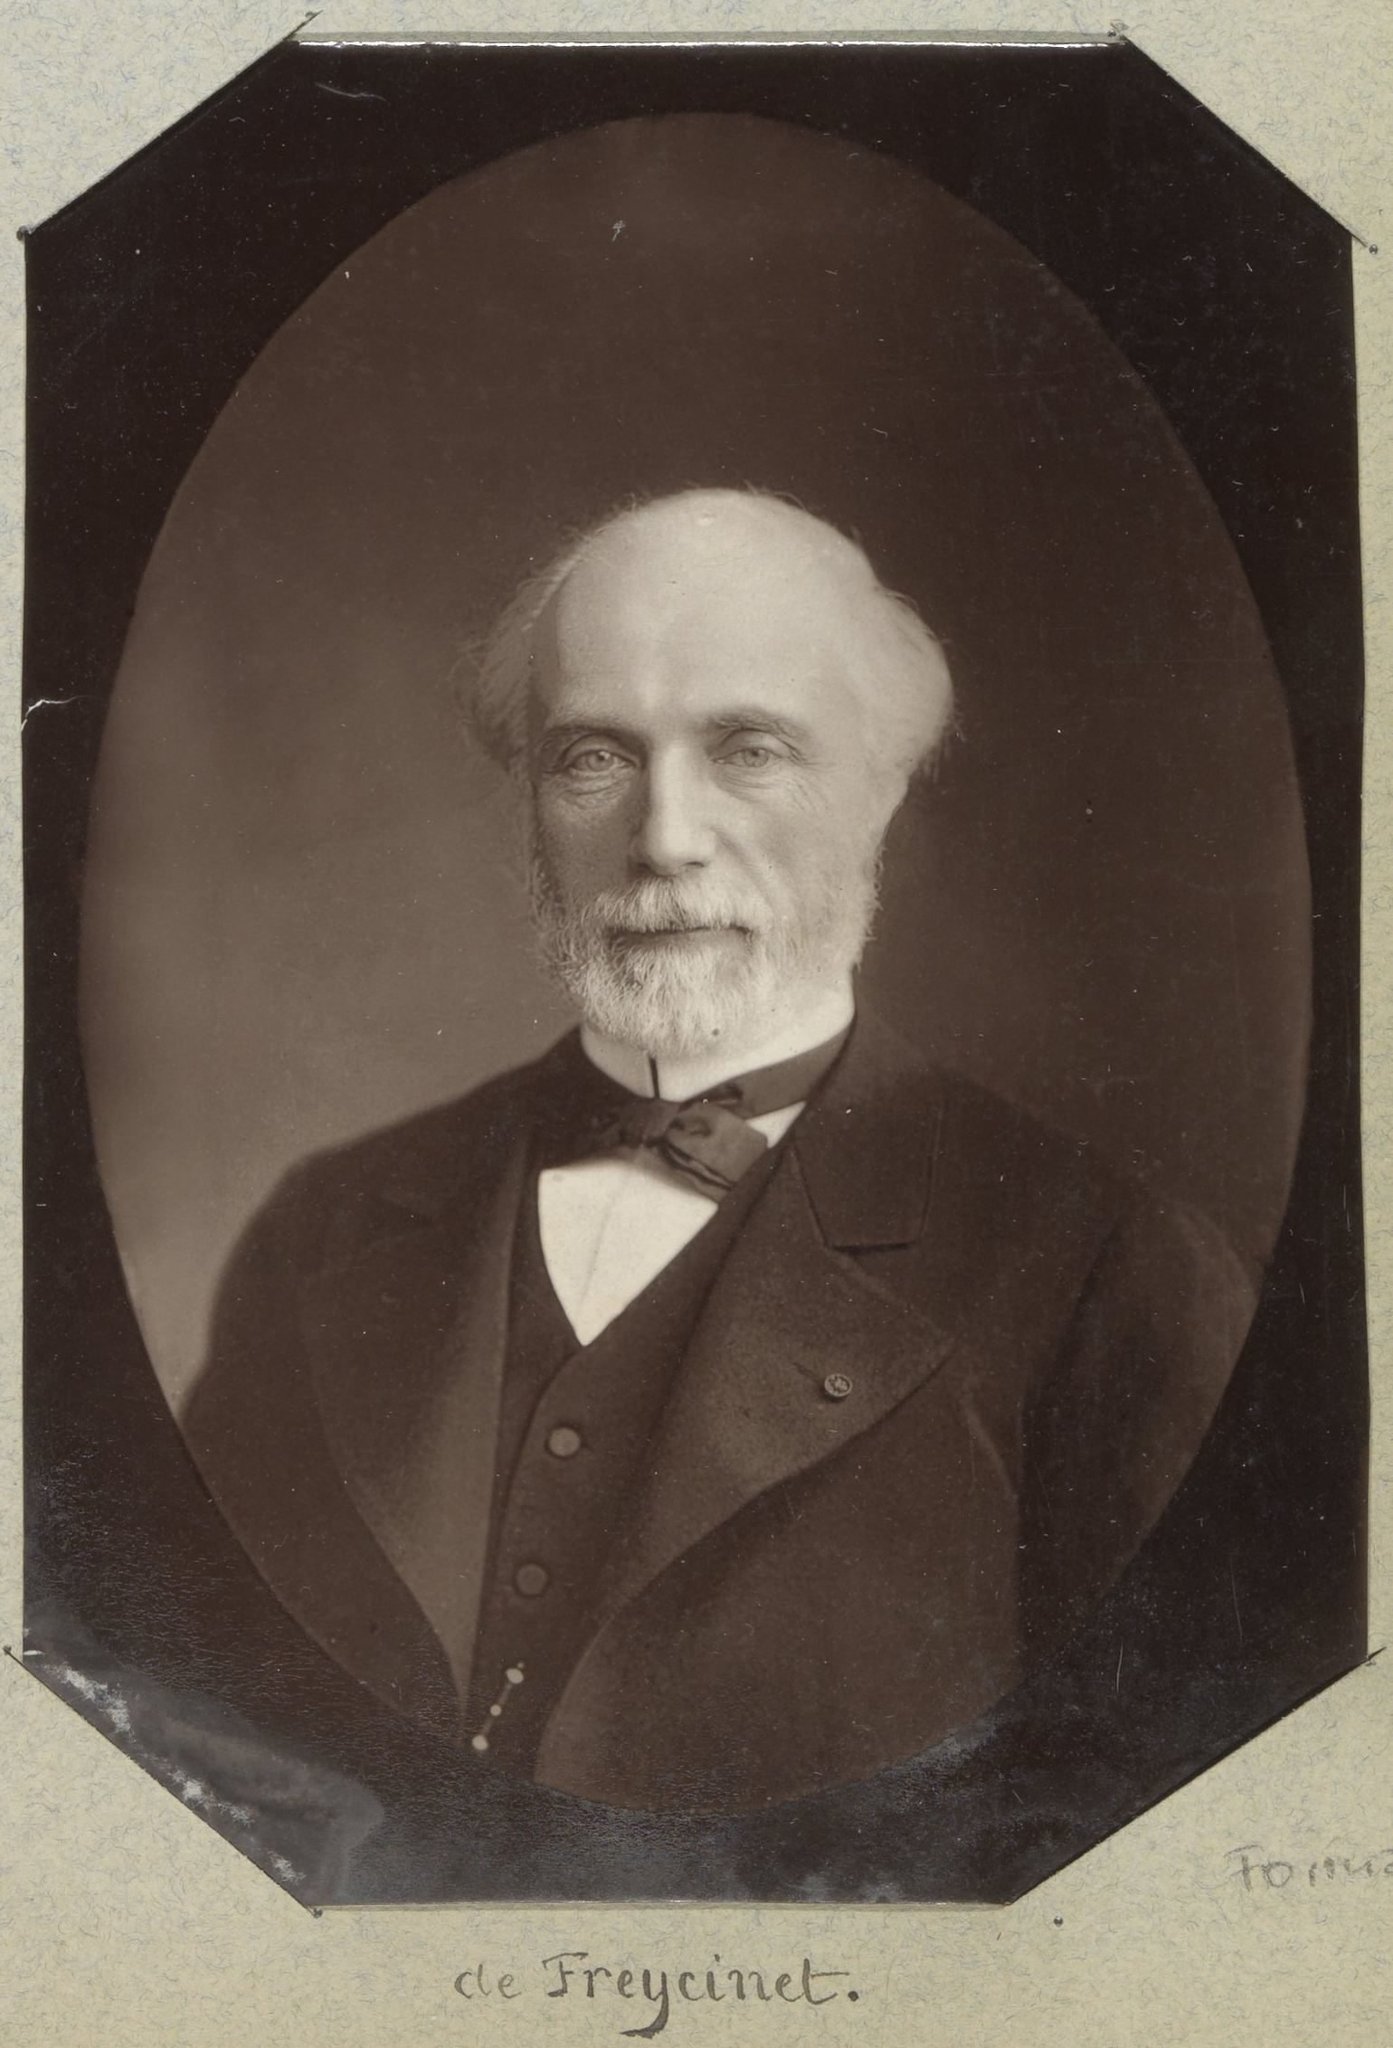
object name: photograph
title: Portret van Charles Louis de Saulces de Freycinet, Frans politicus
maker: Anonymous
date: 1880-1900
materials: paper, photographic support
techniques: carbon print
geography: france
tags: politician, e.g. party leader, france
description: Onderdeel van Album van een Franse amateur met foto's van Frankrijk, Algerije, Palmyra, de Wereldtentoonstelling van 1900 en van bekende Fransen.